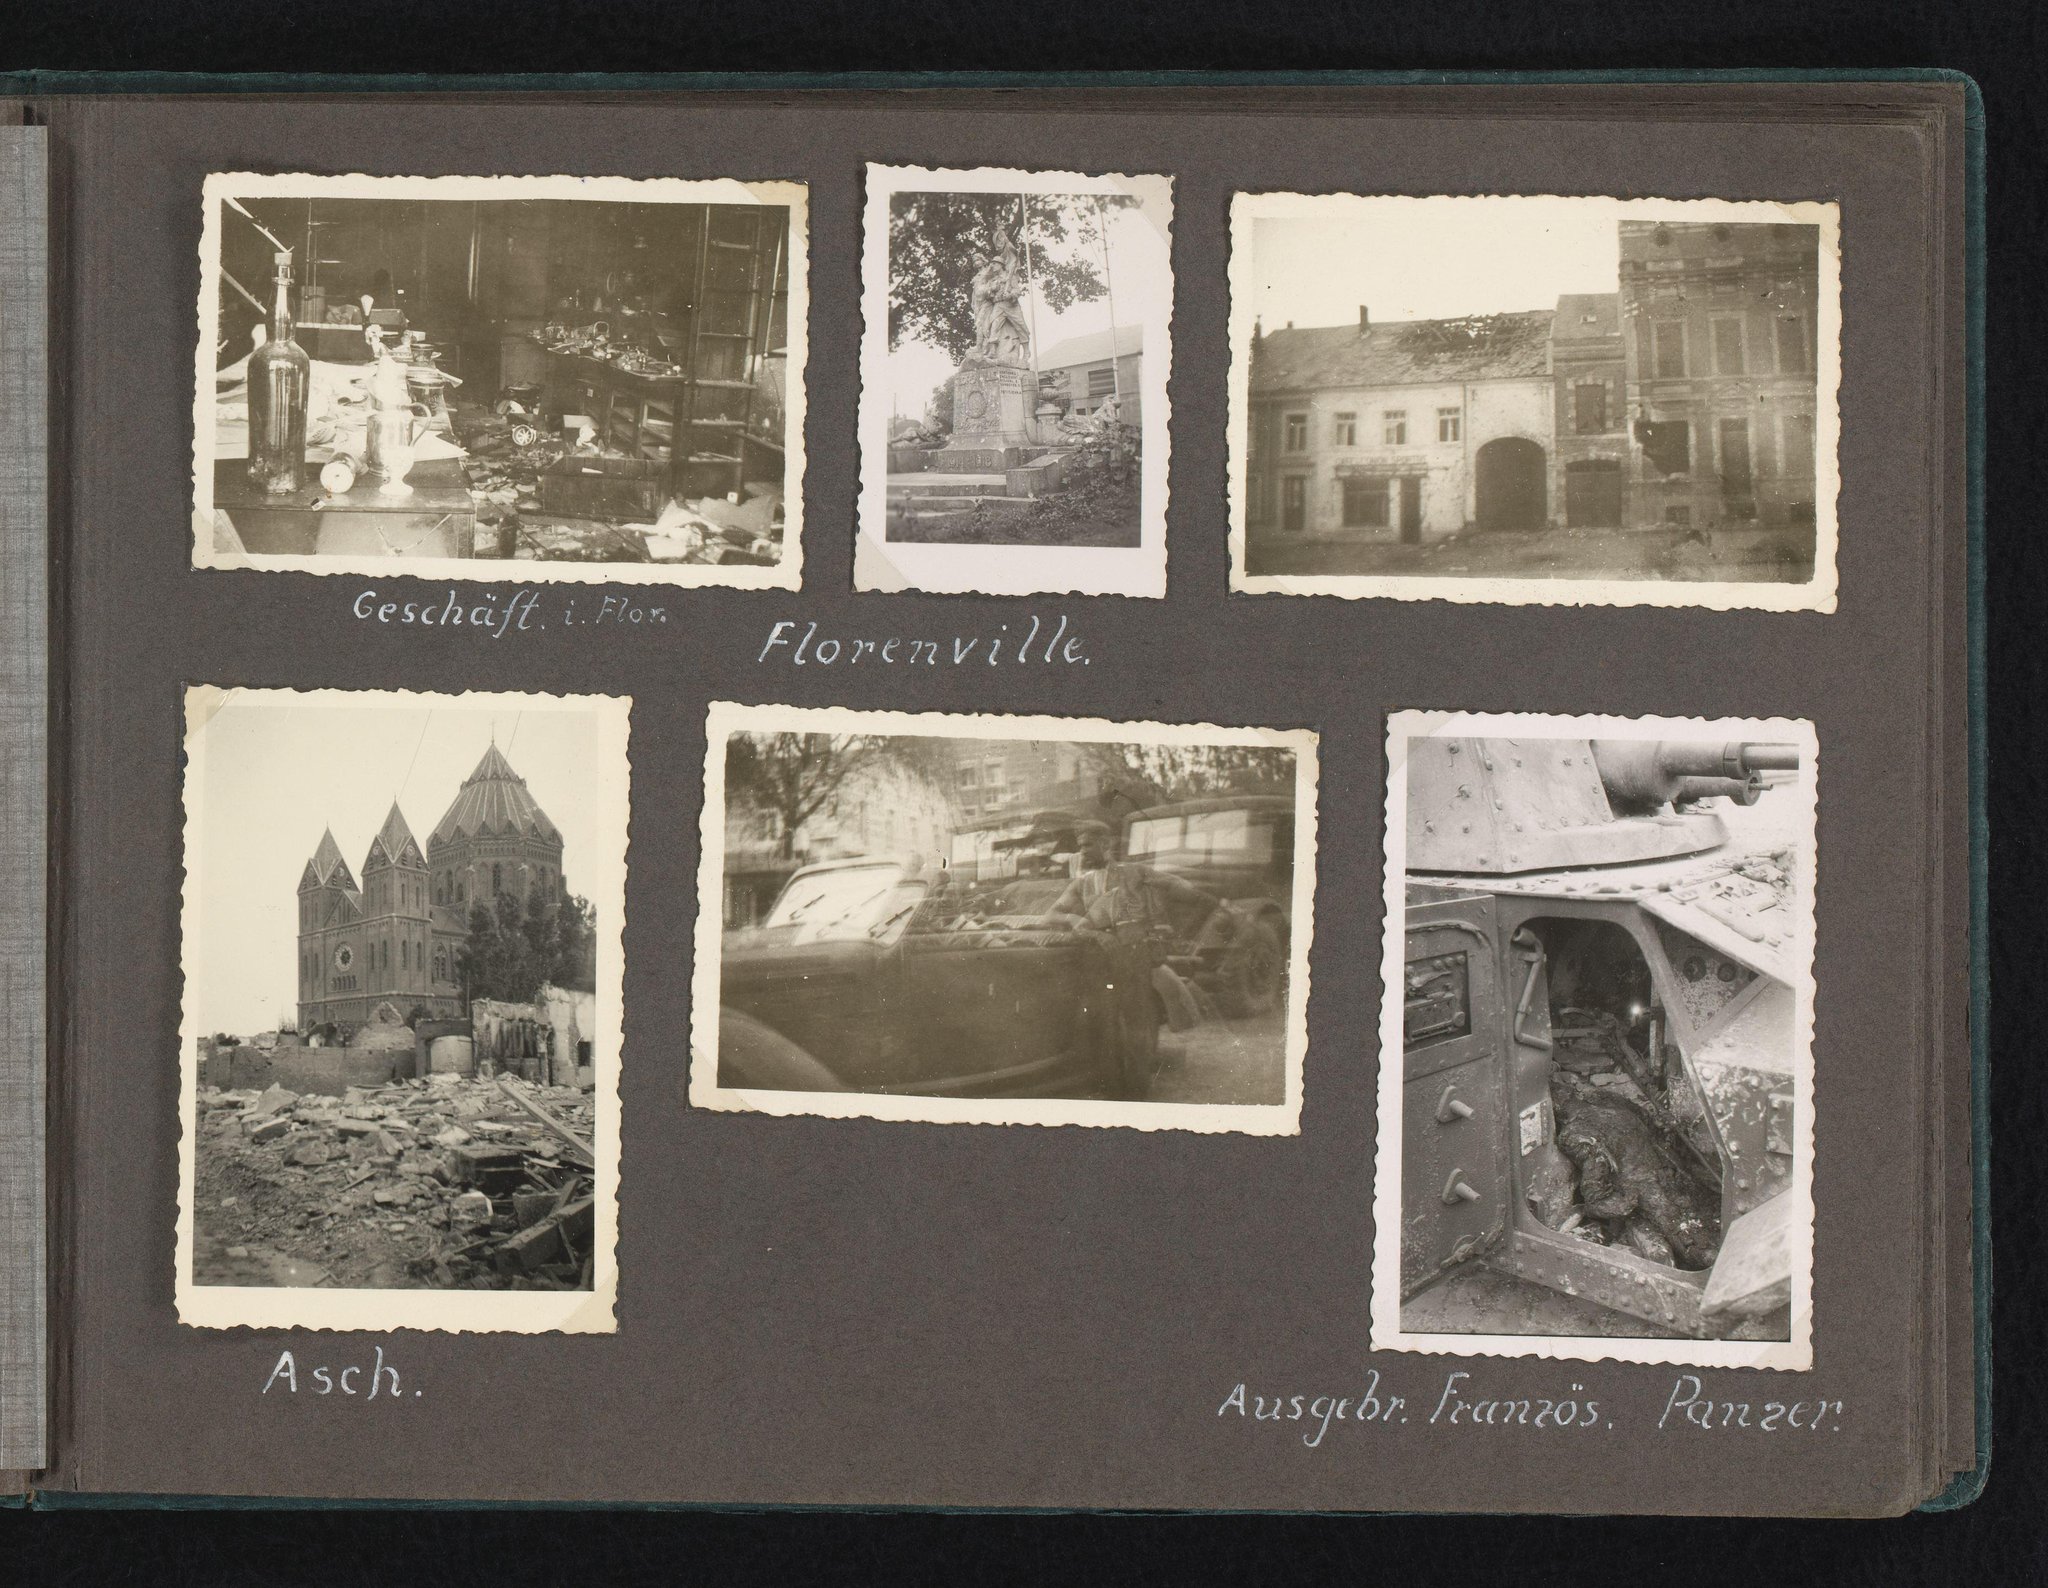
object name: album leaf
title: Luxemburg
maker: Anonymous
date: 1940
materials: cardboard, photographic support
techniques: gelatin silver print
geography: luxembourg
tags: army 'en route', devastated, ruined place or city (~ warfare)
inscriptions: inscription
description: Albumblad met zes foto's onderweg door Luxemburg, met gezichten te Florenville en Asch en van een uitgebrande Franse pantservoertuig. Onderdeel van het fotoalbum 'Kriegserinnerungen' 1940-1945.